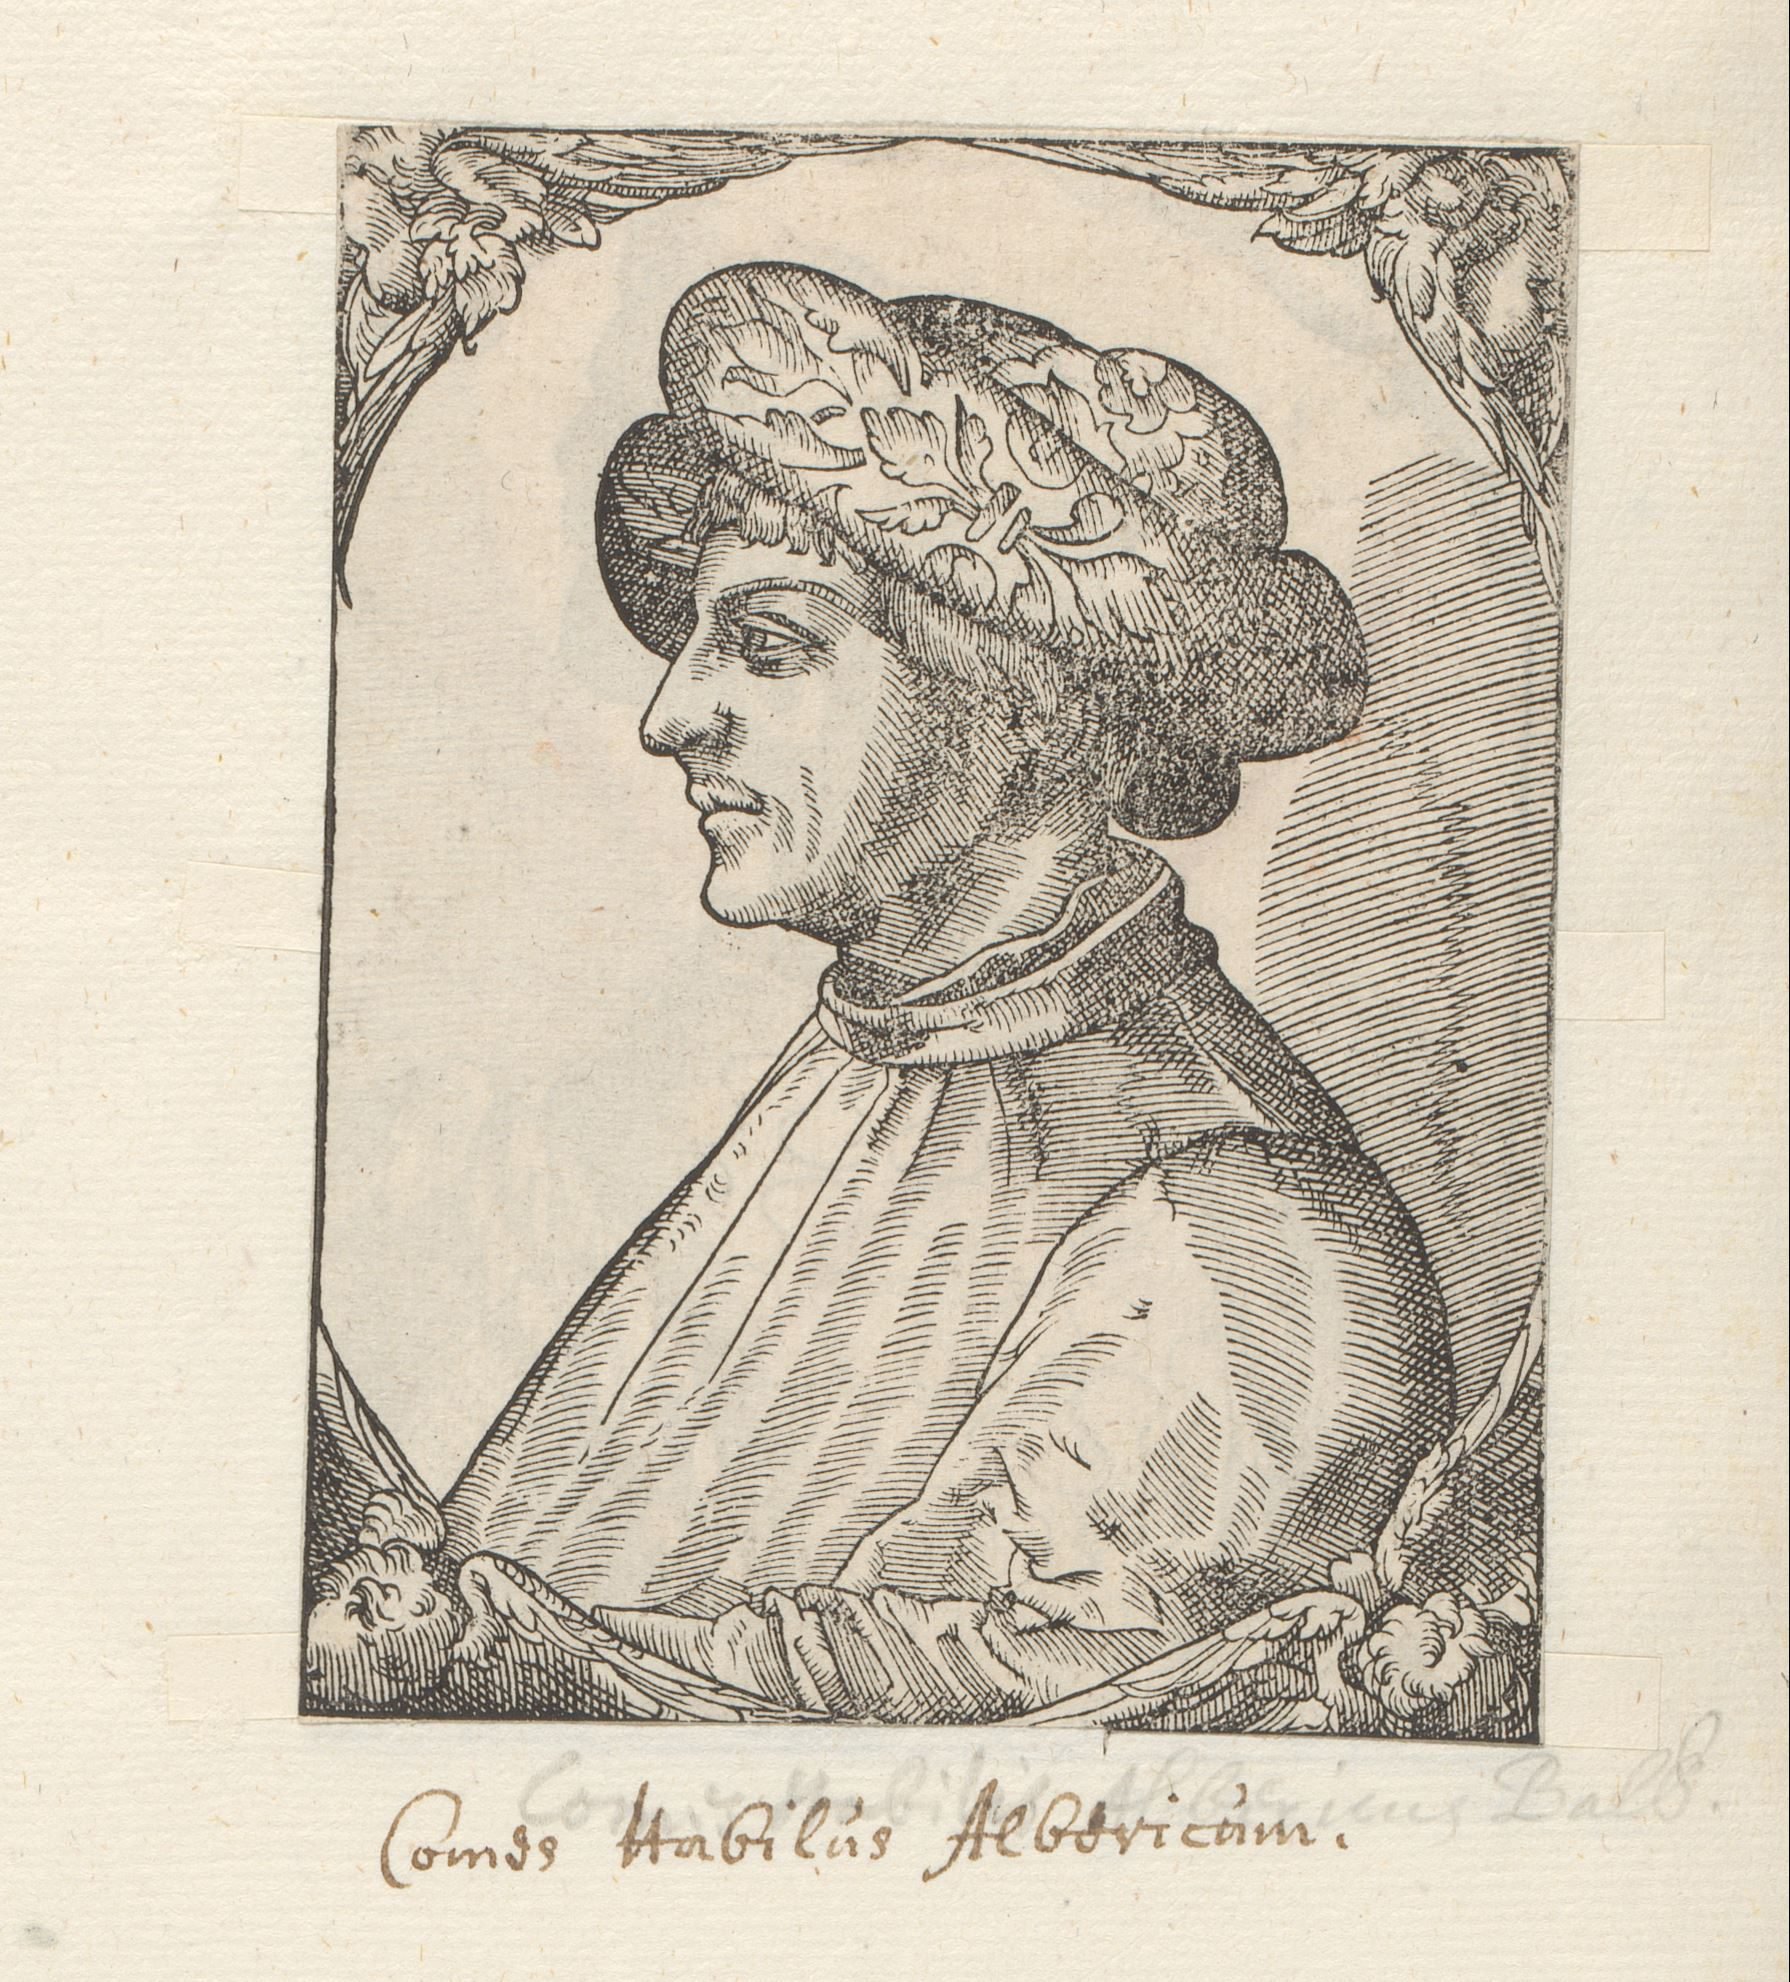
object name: book illustration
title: Portret van Alberico da Barbiano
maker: Anonymous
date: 1549-1575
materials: paper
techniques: woodcut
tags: commander-in-chief, general, marshal, historical persons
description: Prent gebruikt in: Giovio, Paolo. Elogia Virorum bellica virtute illustrium (...). Bazel: Peter Perna, 1575.